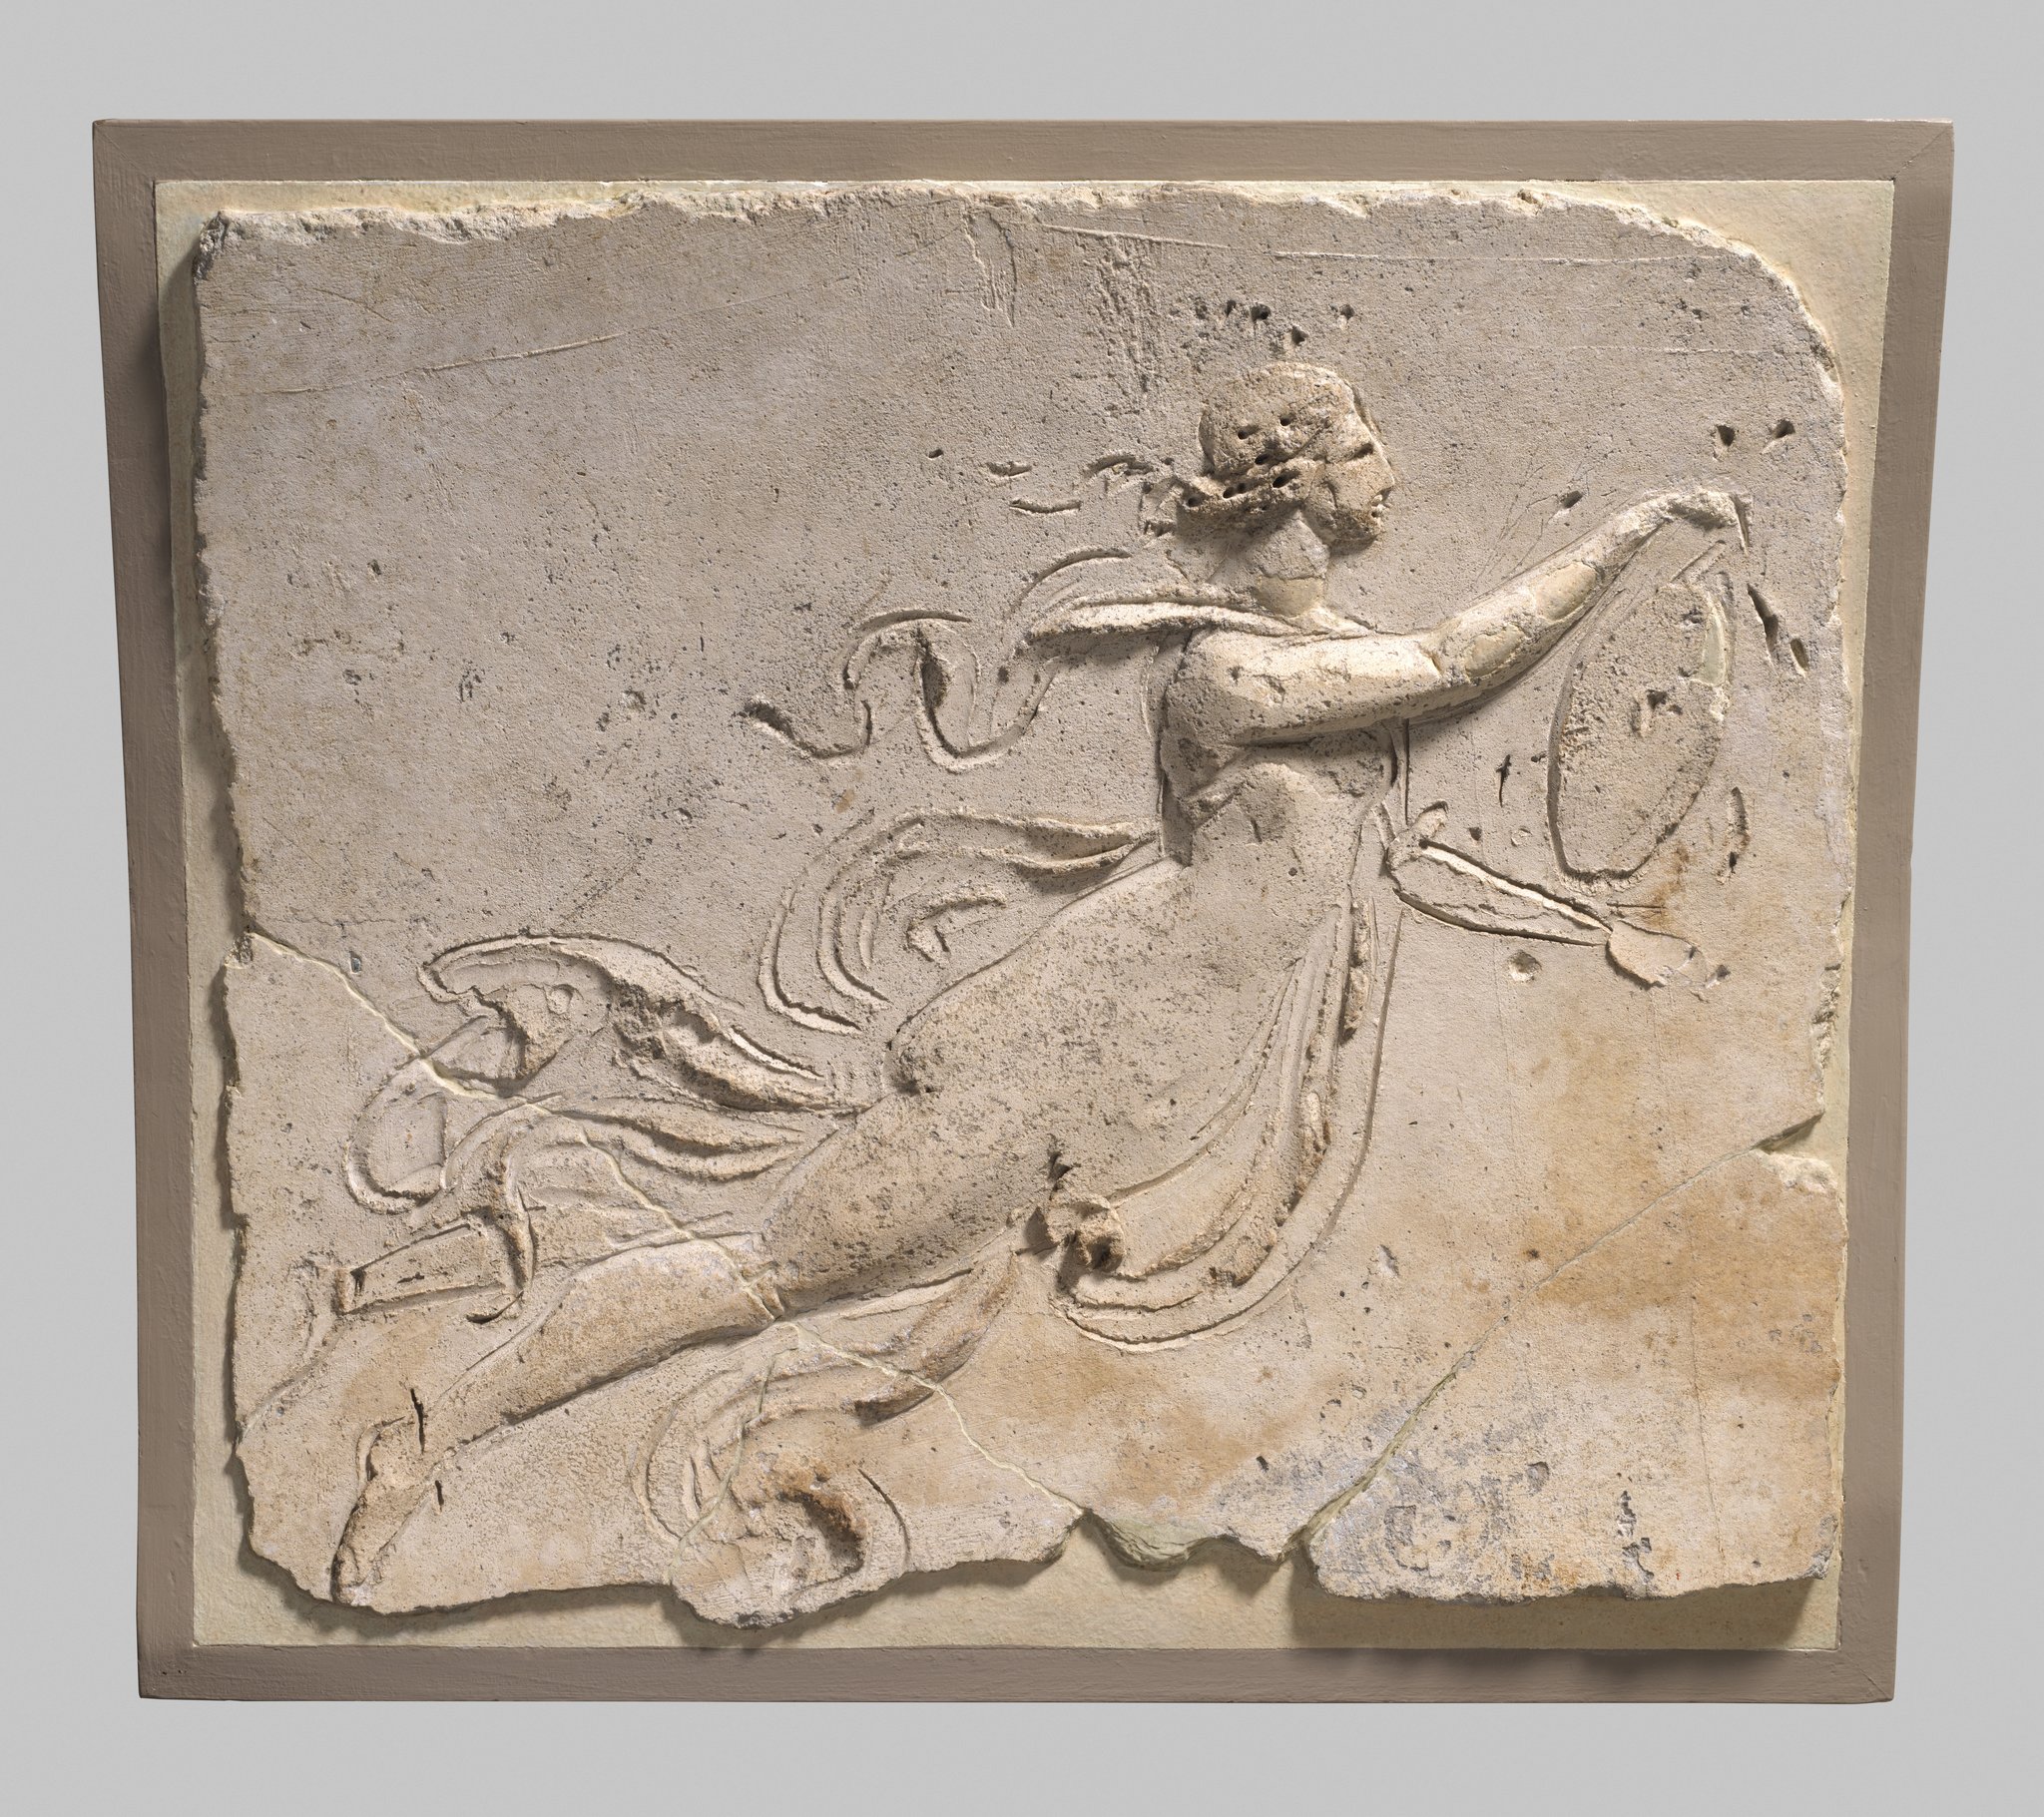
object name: stucco relief of maenad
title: Stucco relief panel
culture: roman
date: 51-100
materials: plaster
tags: women,maenads